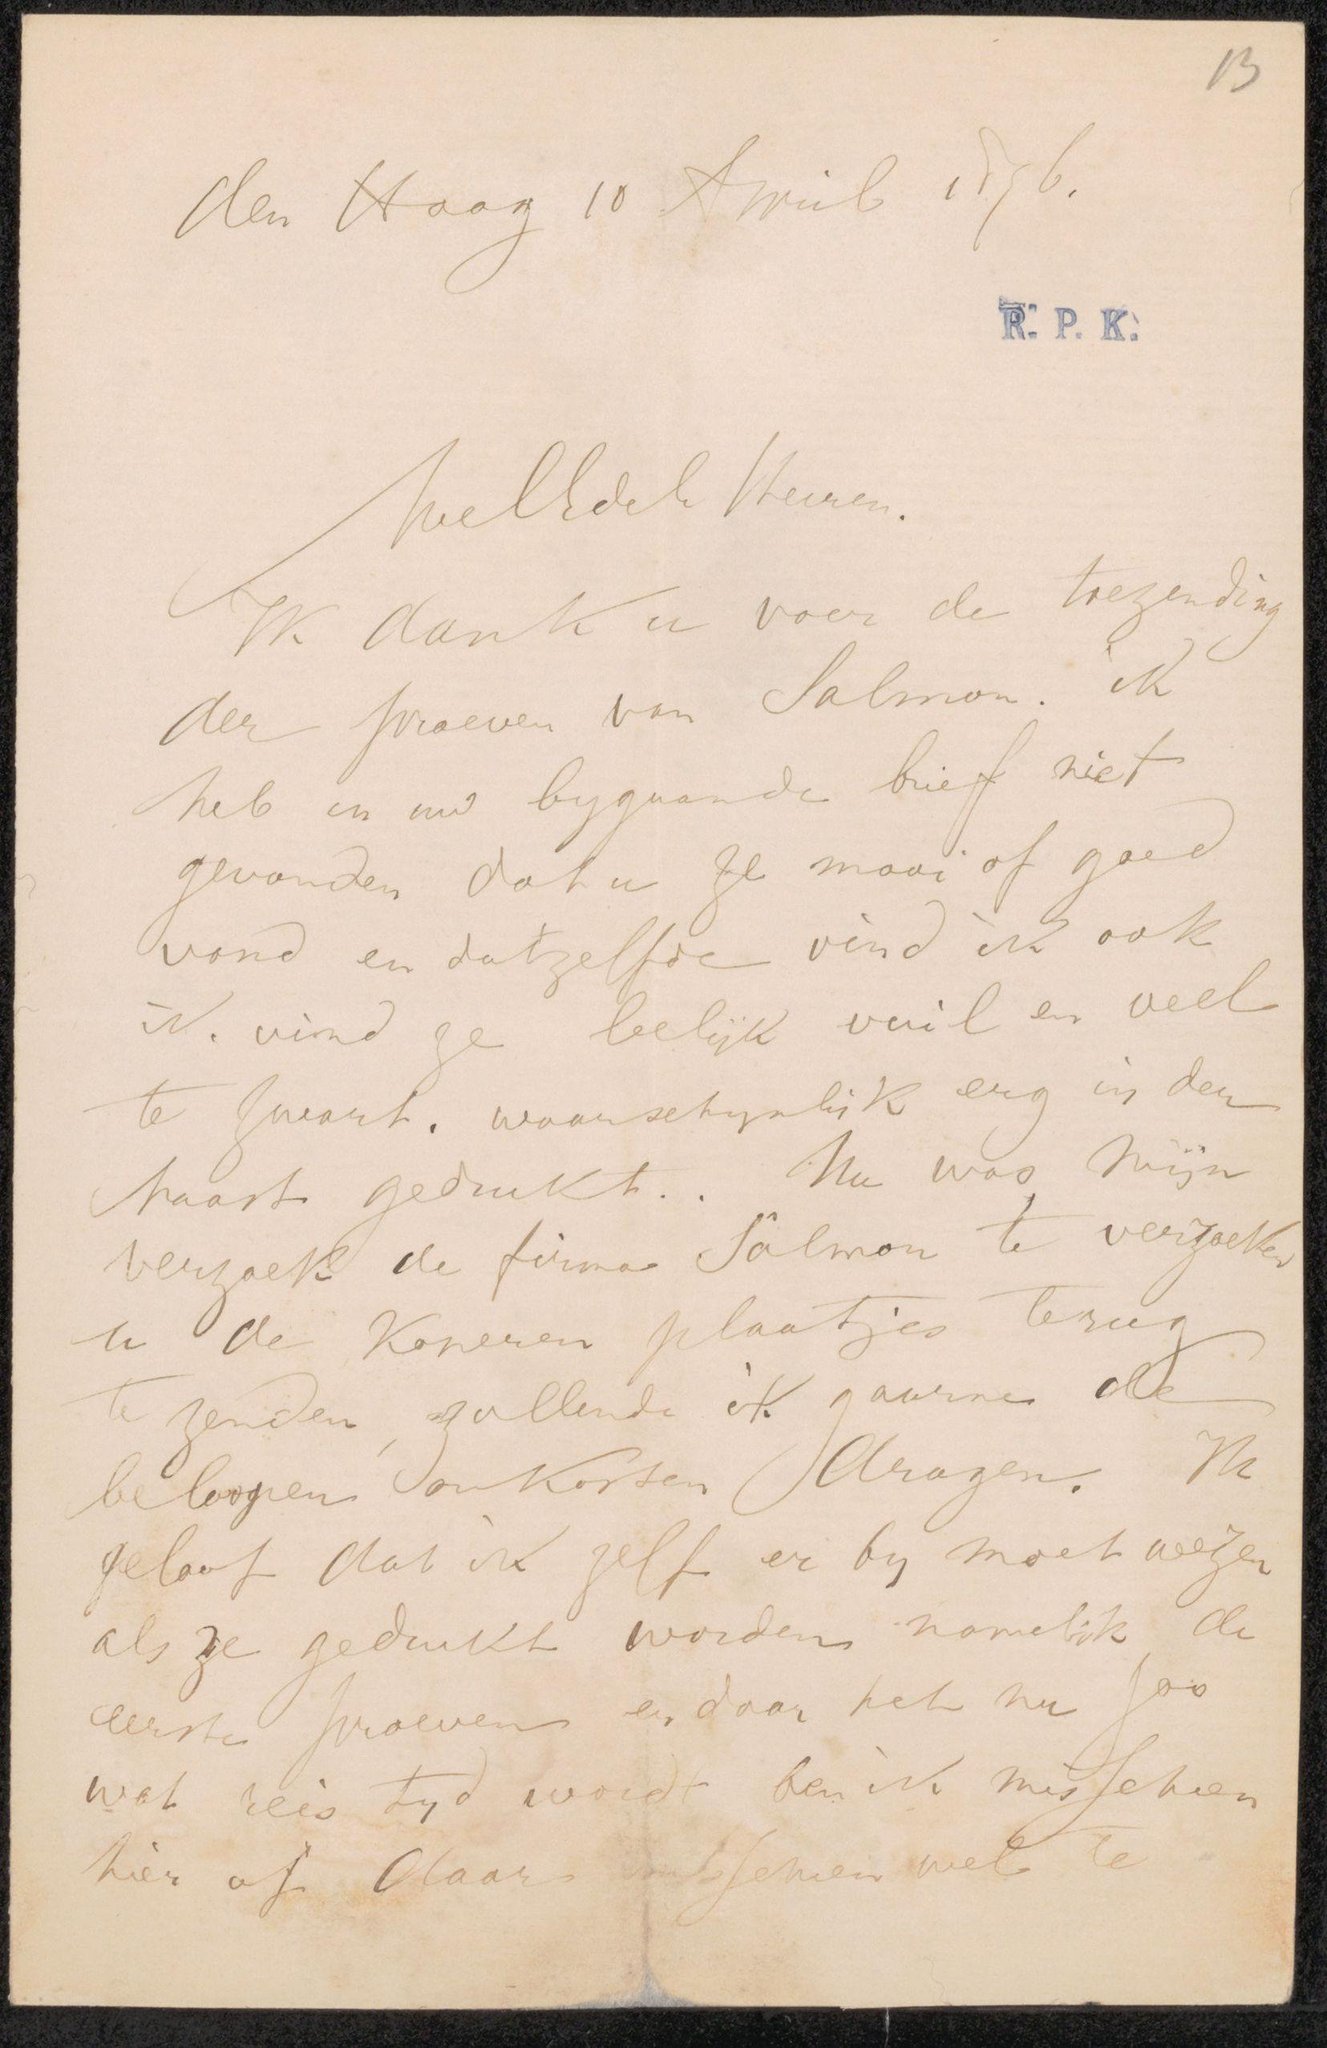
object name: letter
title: Brief aan Frans Buffa en Zonen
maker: jozef israëls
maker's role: draughtsman, painter, print maker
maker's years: 1824-1911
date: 1876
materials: ink, paper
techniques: pen, writing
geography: the hague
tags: printer, georg friedrich felsing, publisher, alfred salmon, jacobus franciscus brugman, the graphic arts, amsterdam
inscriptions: collector's mark: Lugt 2233